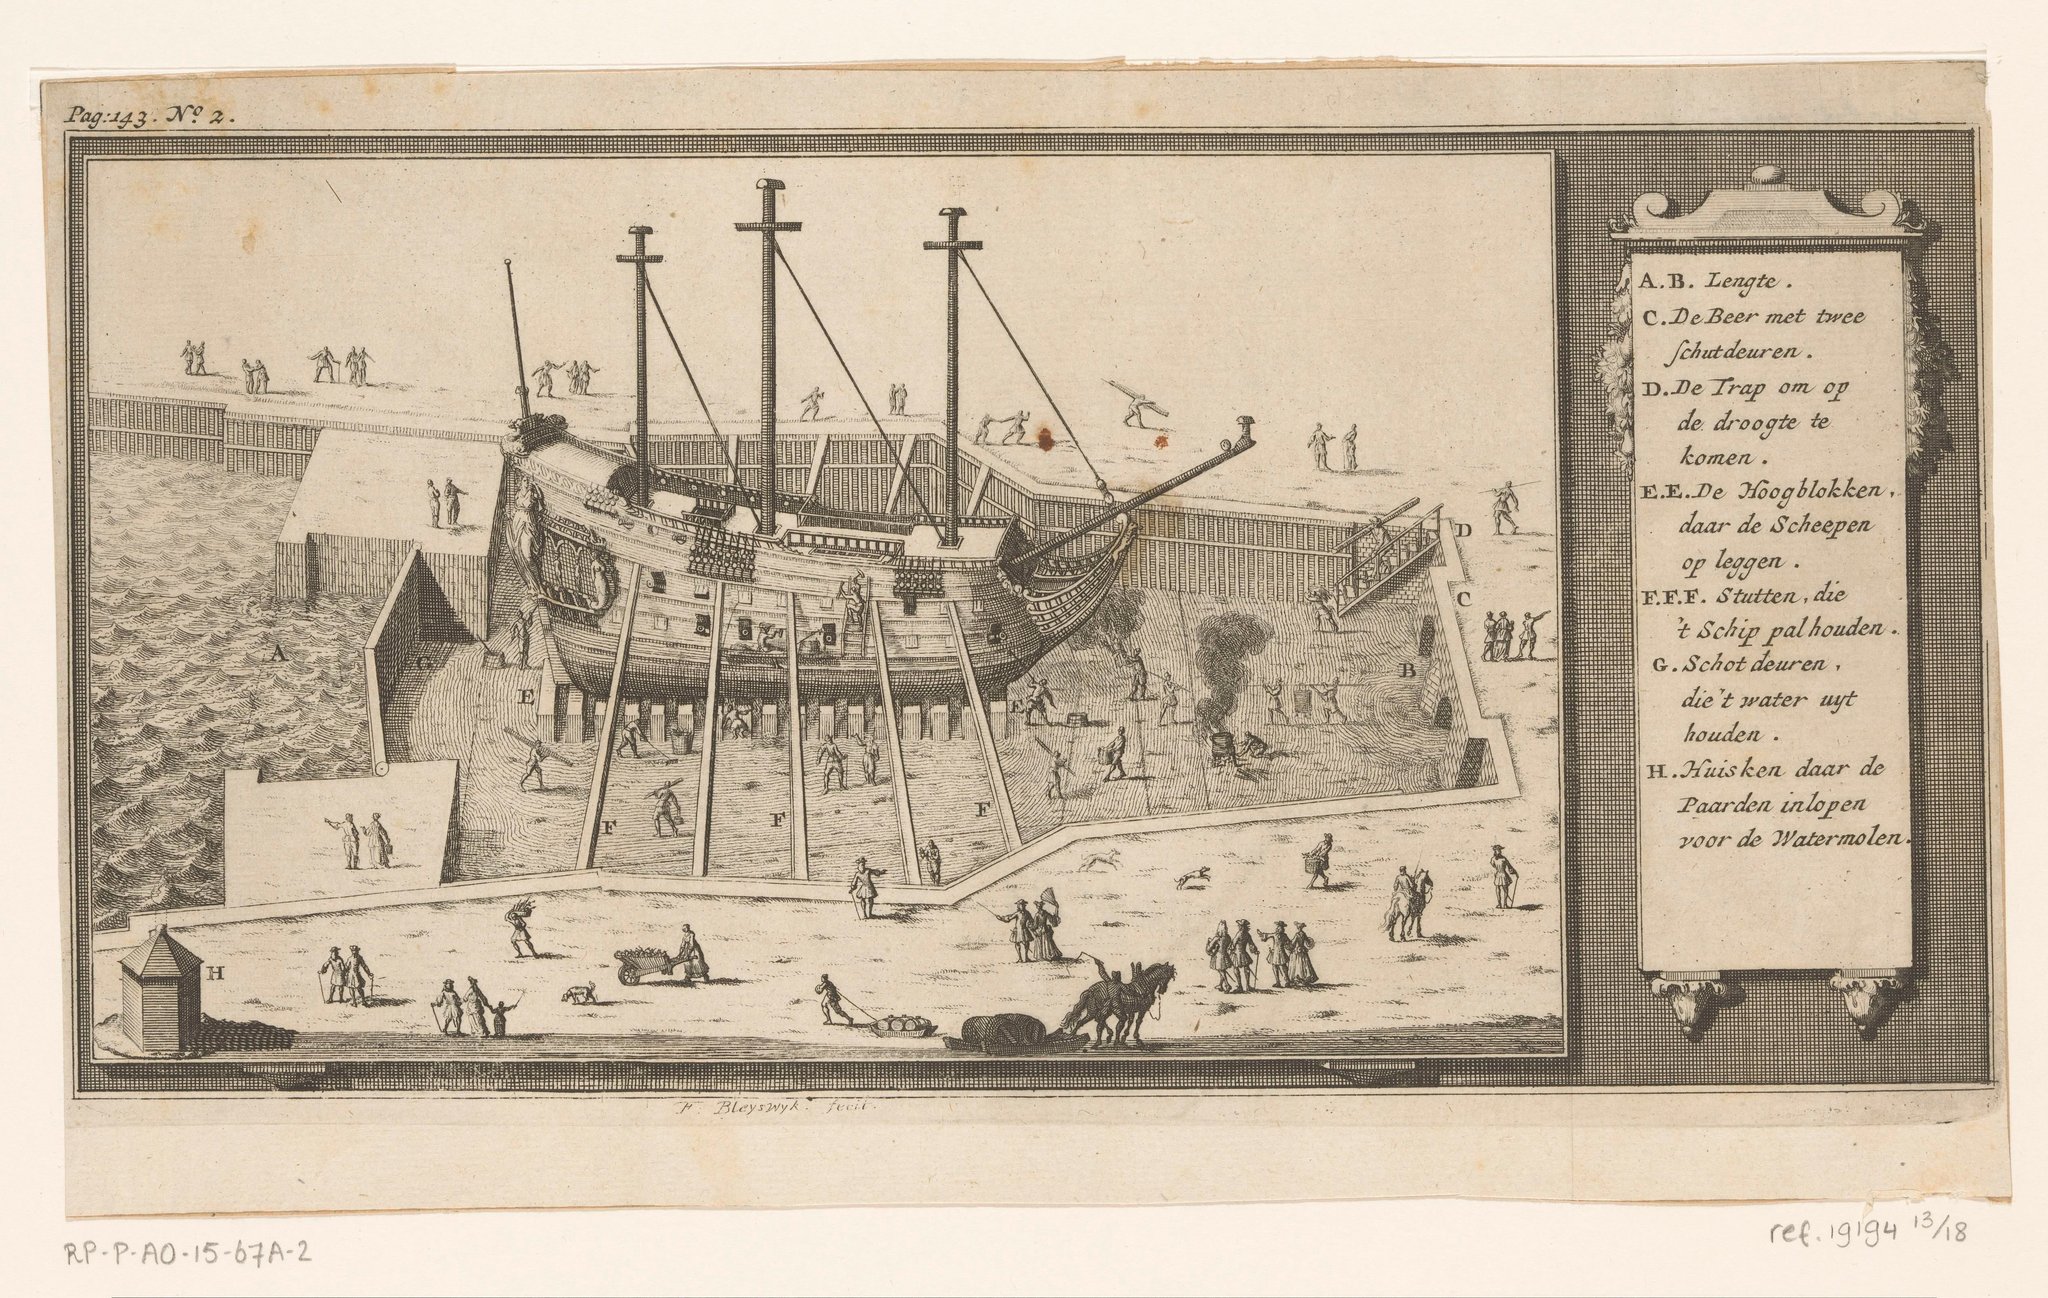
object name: book illustration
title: Schip in droogdok te Vlissingen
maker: françois van bleyswijck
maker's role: draughtsman, print maker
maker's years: 1671-1746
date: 1717-1755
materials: paper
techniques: engraving, etching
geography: leiden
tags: building a ship, ship under construction, shipyard-workers, dry-dock, floating-dock, flushing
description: Prent ook gebruikt in: Gargon, Mattheus. Walchersche arkadia, waar in op een zoetvoerigen trant (…). 2 delen. Leiden: Samuel Luchtmans, 1715-1717, dl. 2 (1717), p. 143. En in: Gargon, Mattheus. Walchersche arkadia, waar in op een zoetvoerigen trant (…). 2 delen. Leiden: Samuel Luchtmans en Zoon, 1746, dl. 2, p. 143. En in: Gargon, Mattheus. Walchersche arkadia, waar in op een zoetvoerigen trant (…). 2 delen. Middelburg: M.H. en A.L. Callenfels, S. Mandelgreen, P. Gillissen en L. Taillefert, 1755, dl. 2, p. 143. Zie RP-P-AO-15-67A-1 voor de bijhorende plattegrond van het droogdok.